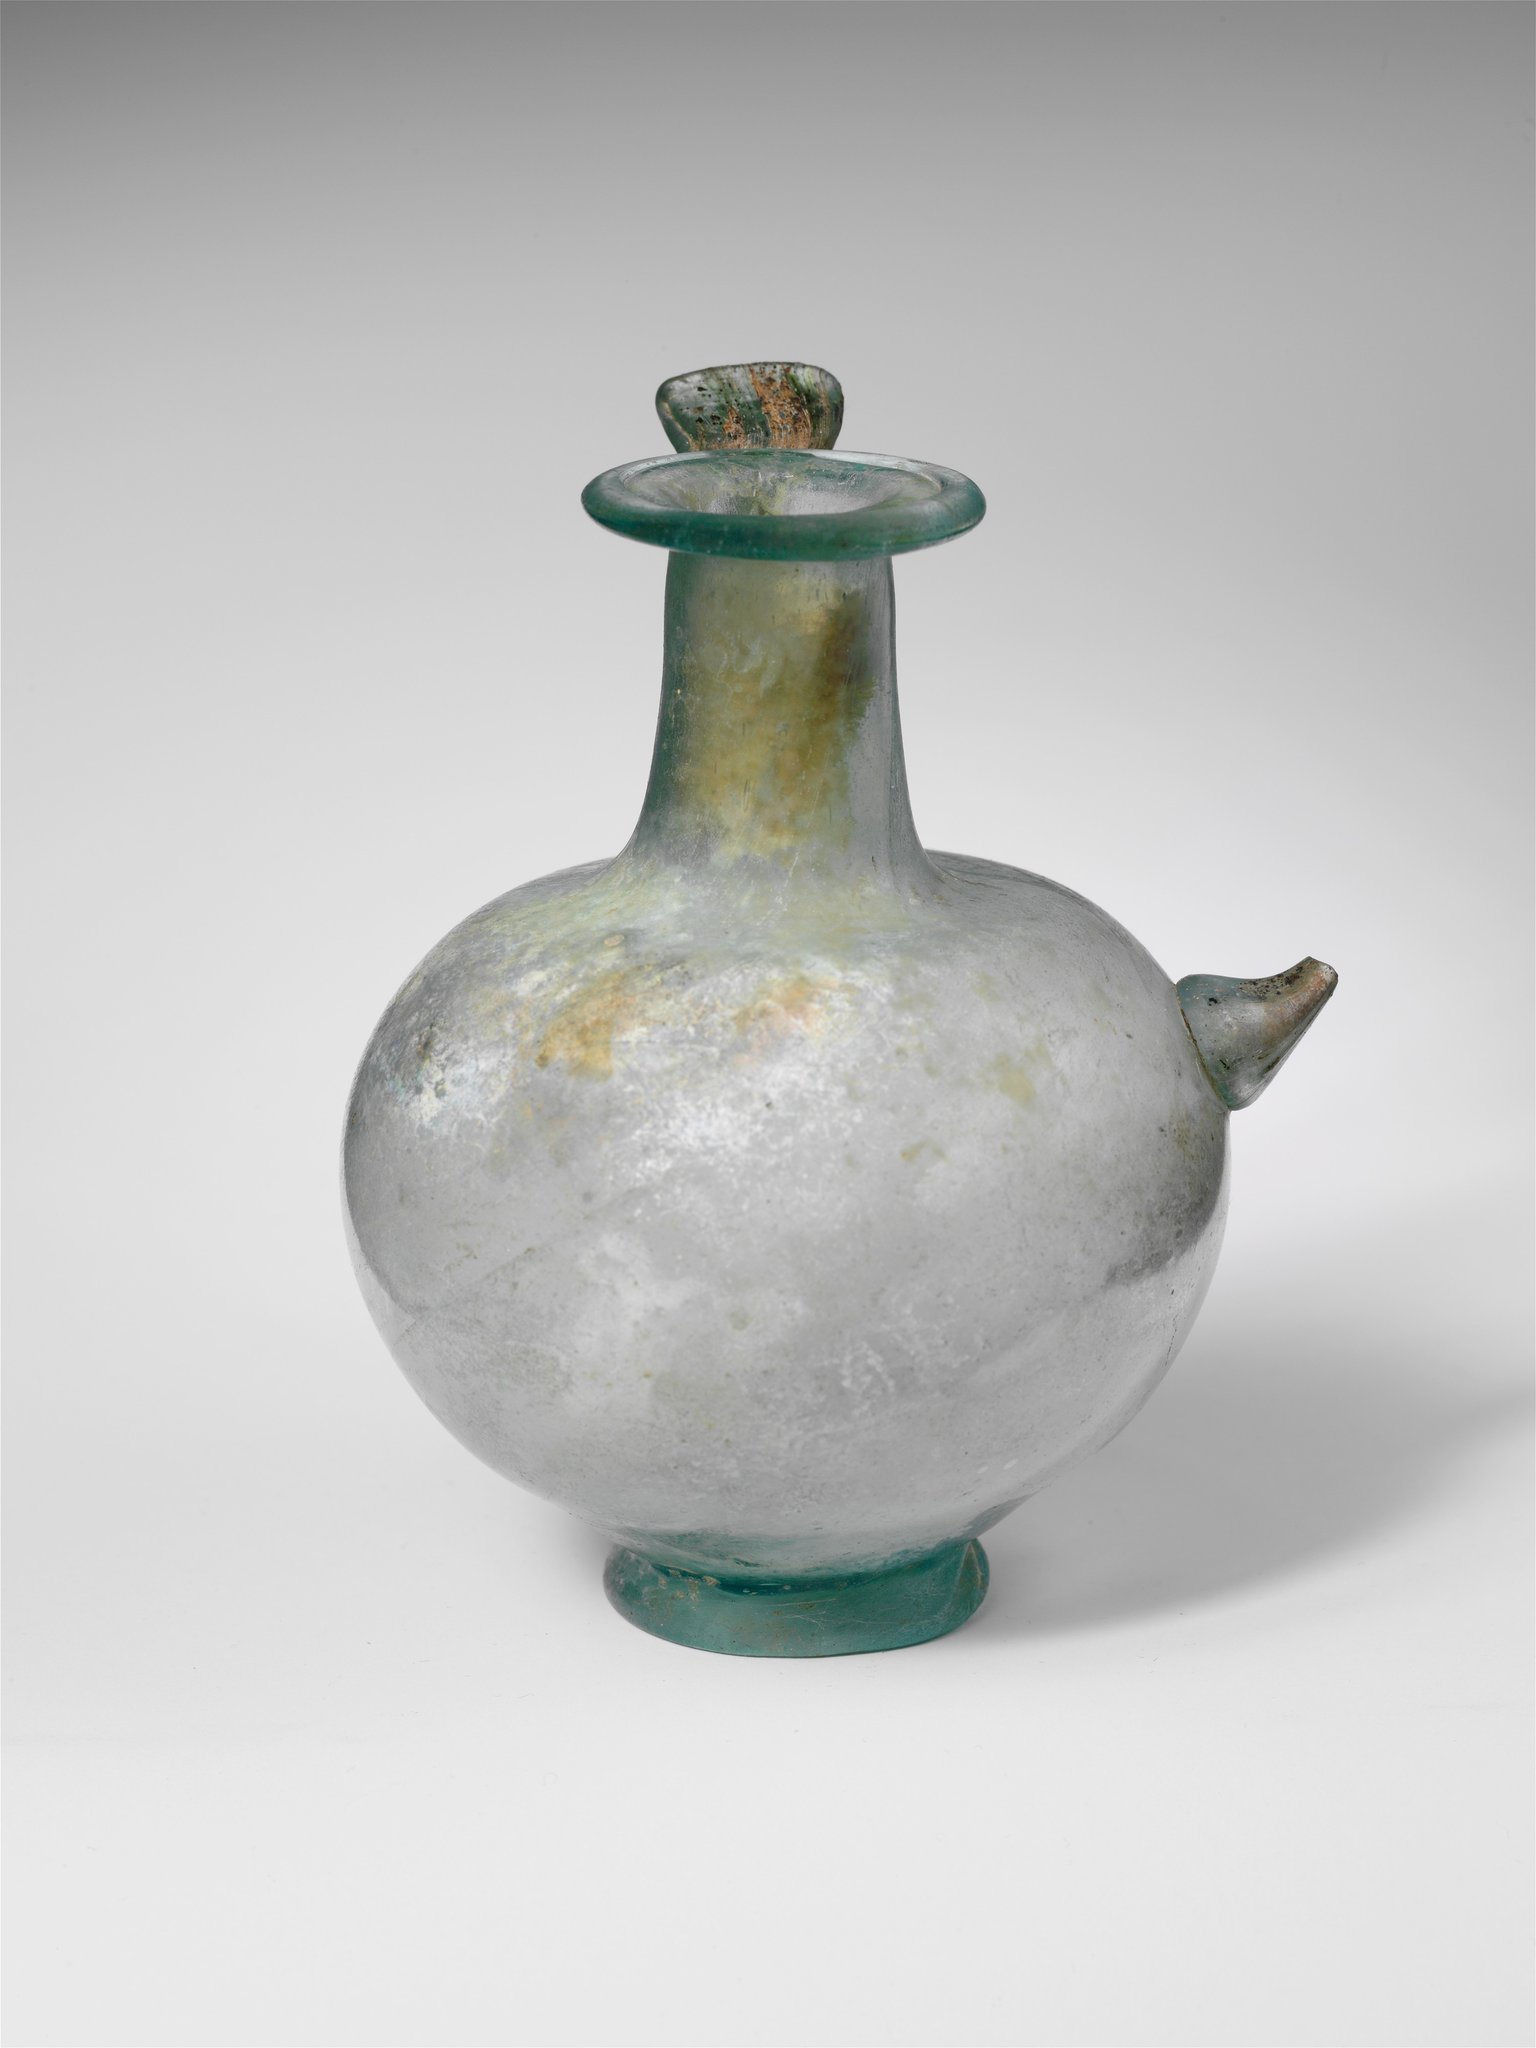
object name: jug, spouted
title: Glass jug with spout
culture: roman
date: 101-300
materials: glass